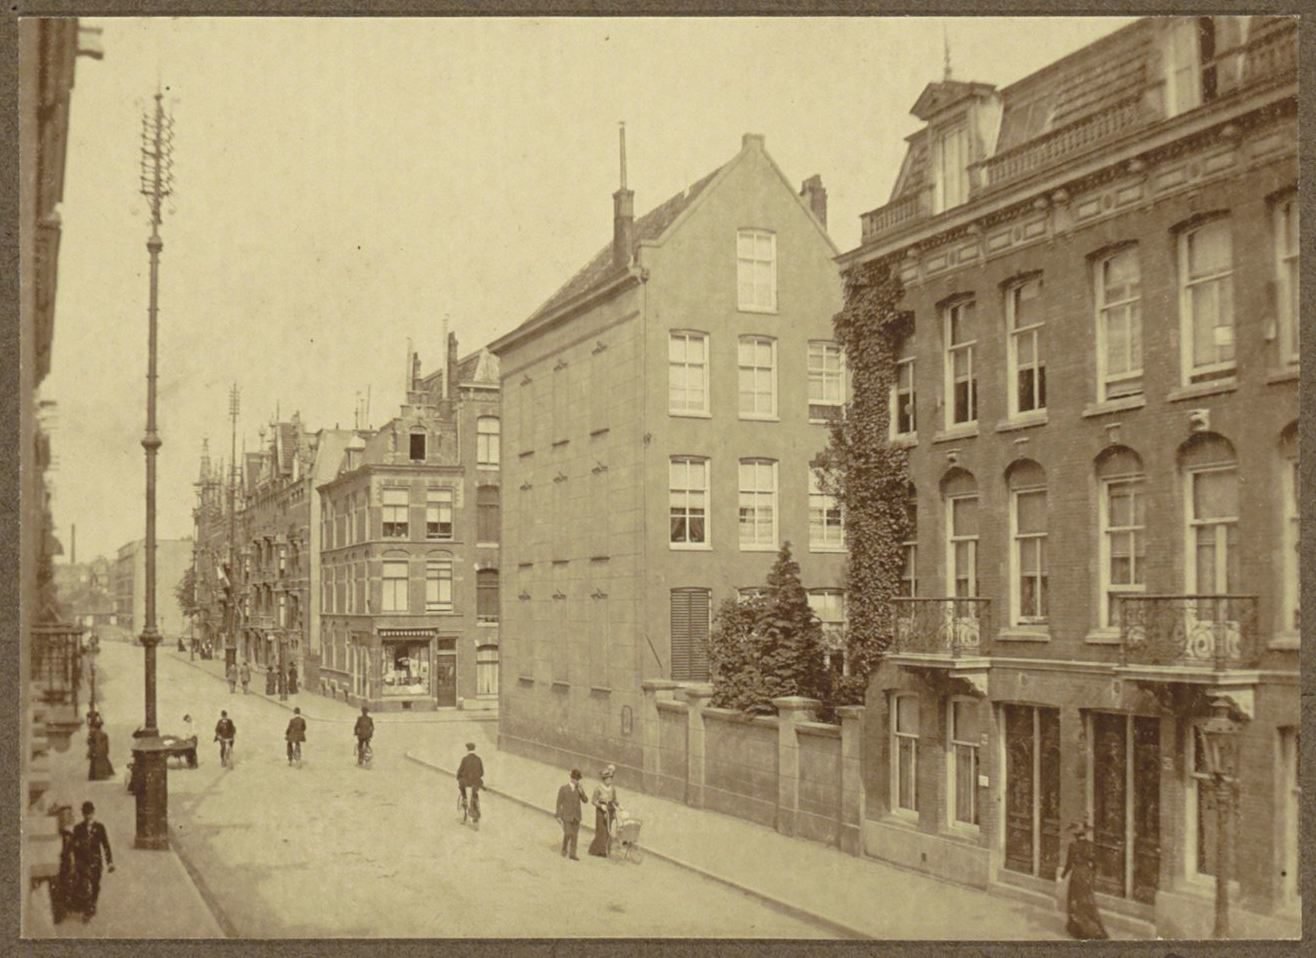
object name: photograph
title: Eerste Helmersstraat te Amsterdam ter hoogte van de kruising met de Tweede Constantijn Huygensstraat, gezien naar het noorden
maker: Anonymous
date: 1910-1930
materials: paper, photographic support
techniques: gelatin silver print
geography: amsterdam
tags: street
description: Onderdeel van Album met foto's van Amsterdam en omgeving.